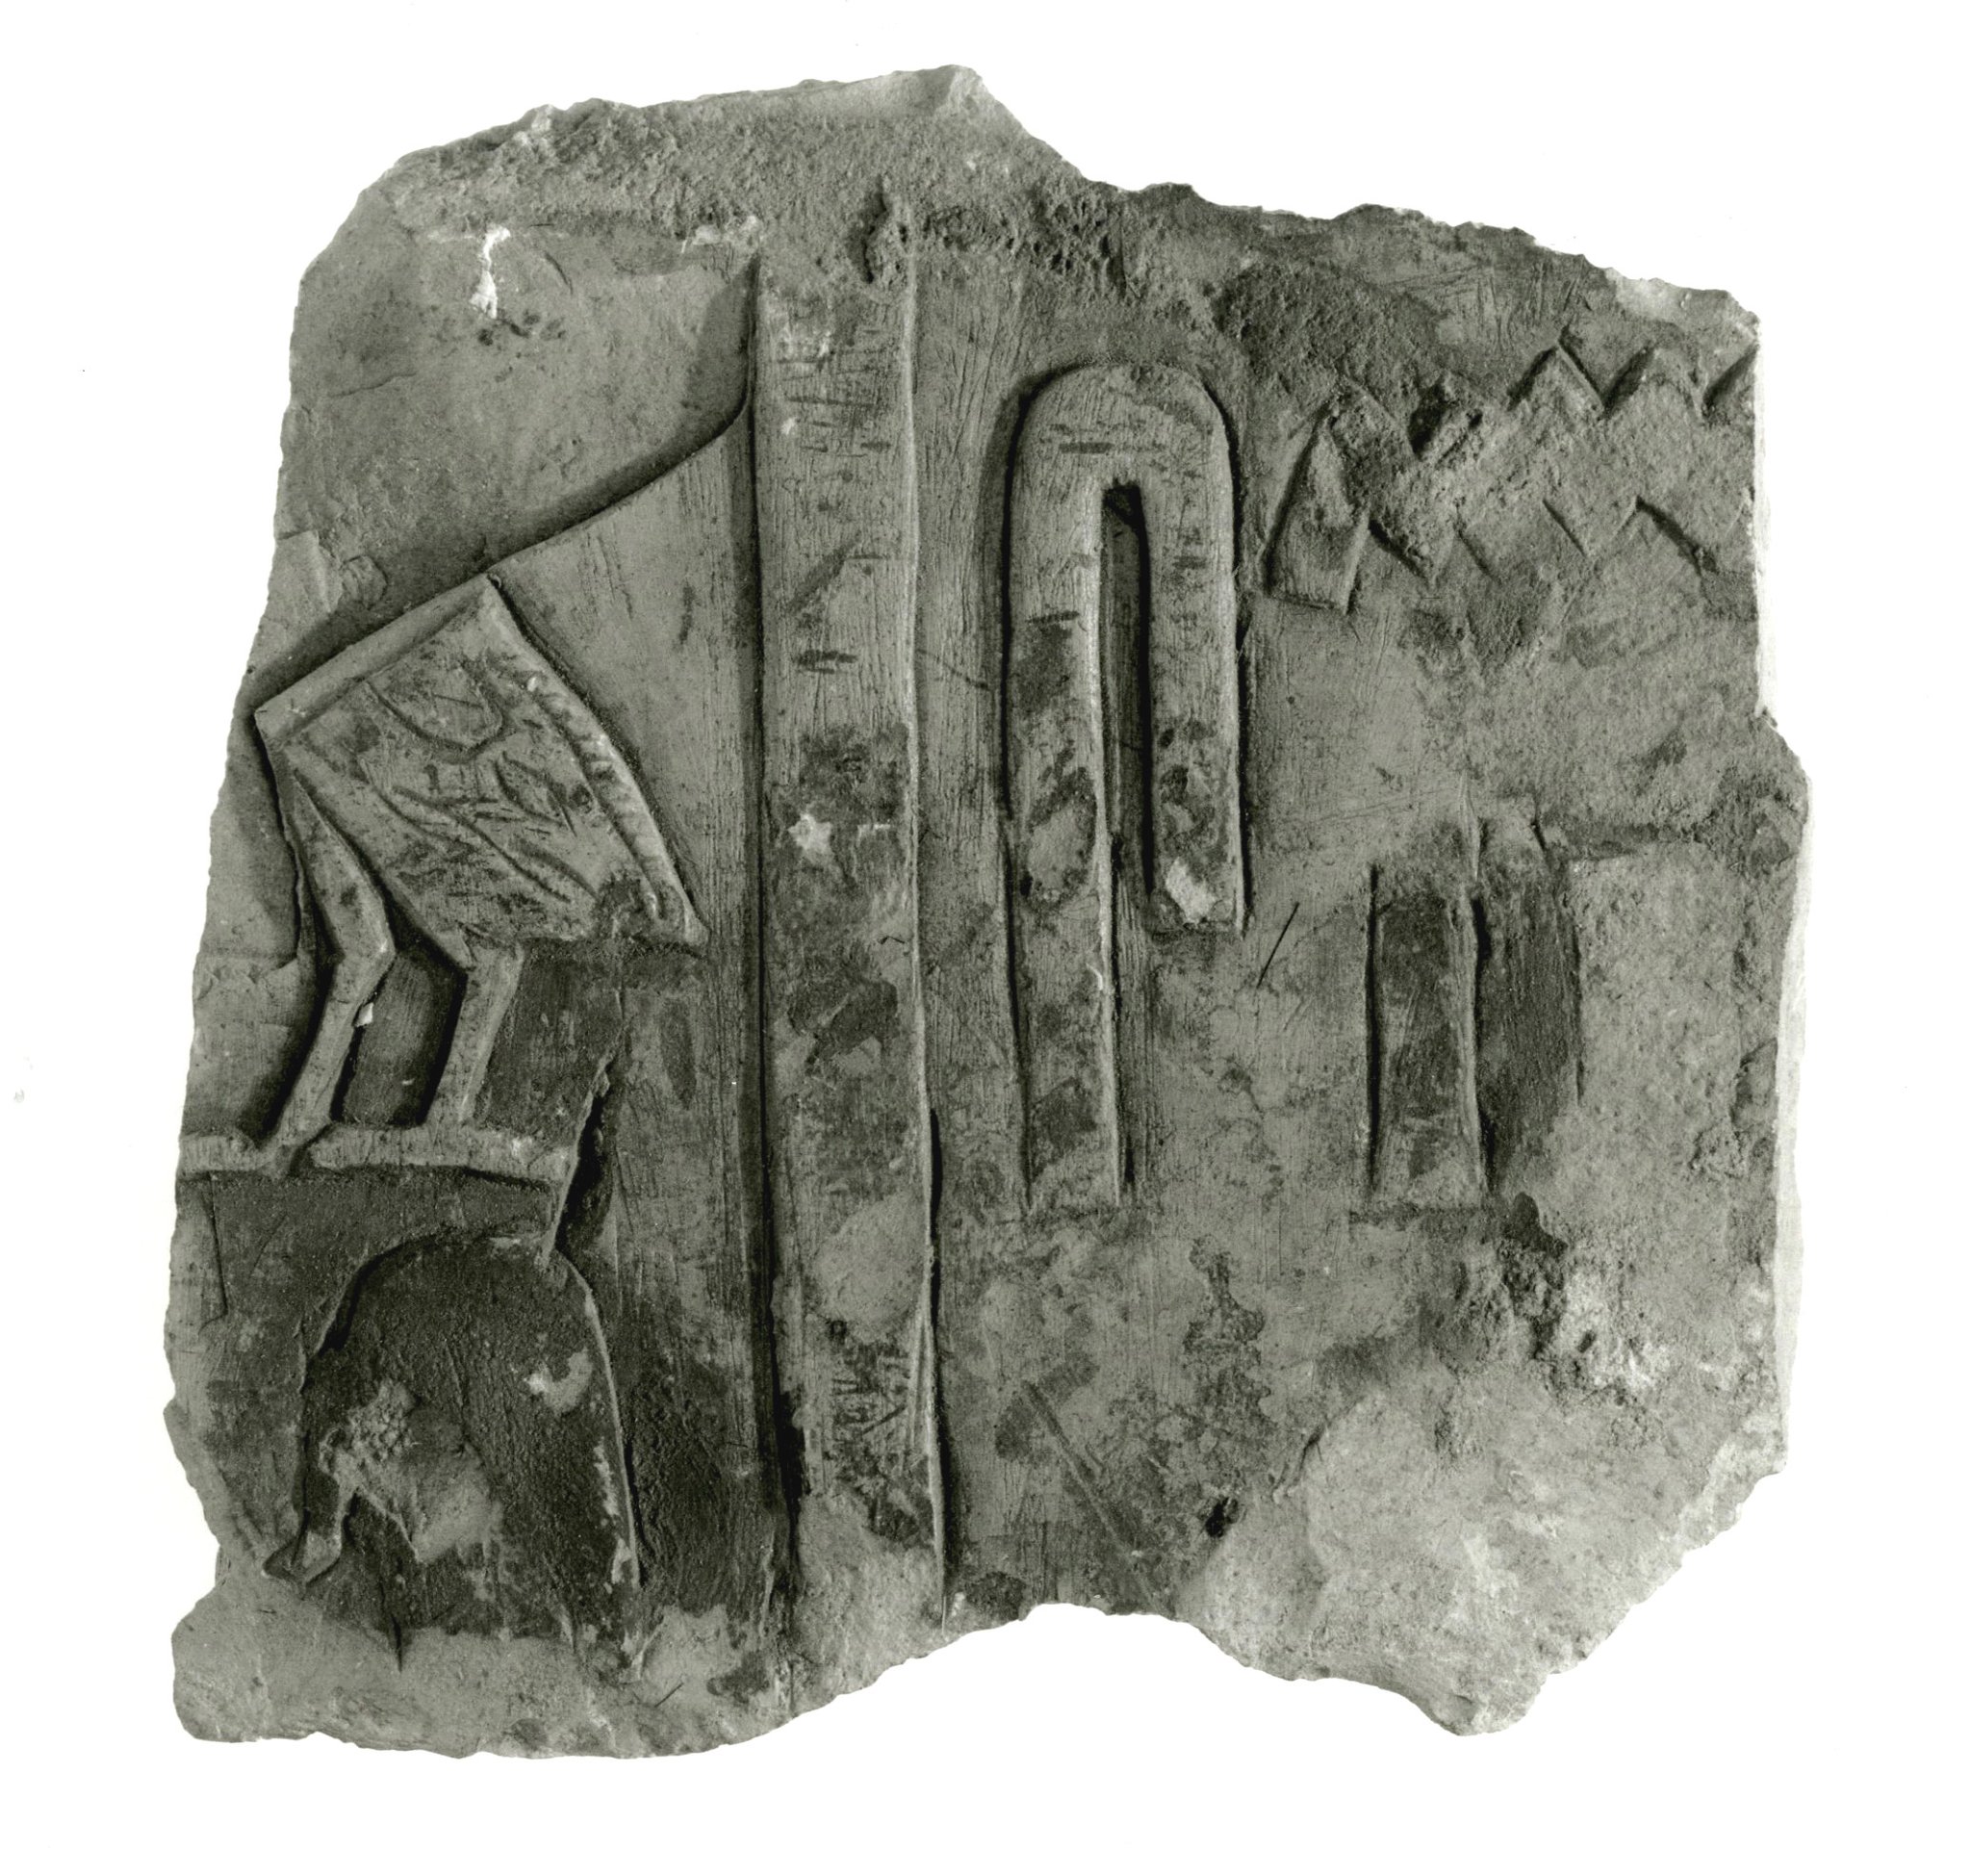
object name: relief, tomb of nespekashuty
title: Raised relief fragment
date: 664-610 BCE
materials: limestone, varnish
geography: egypt